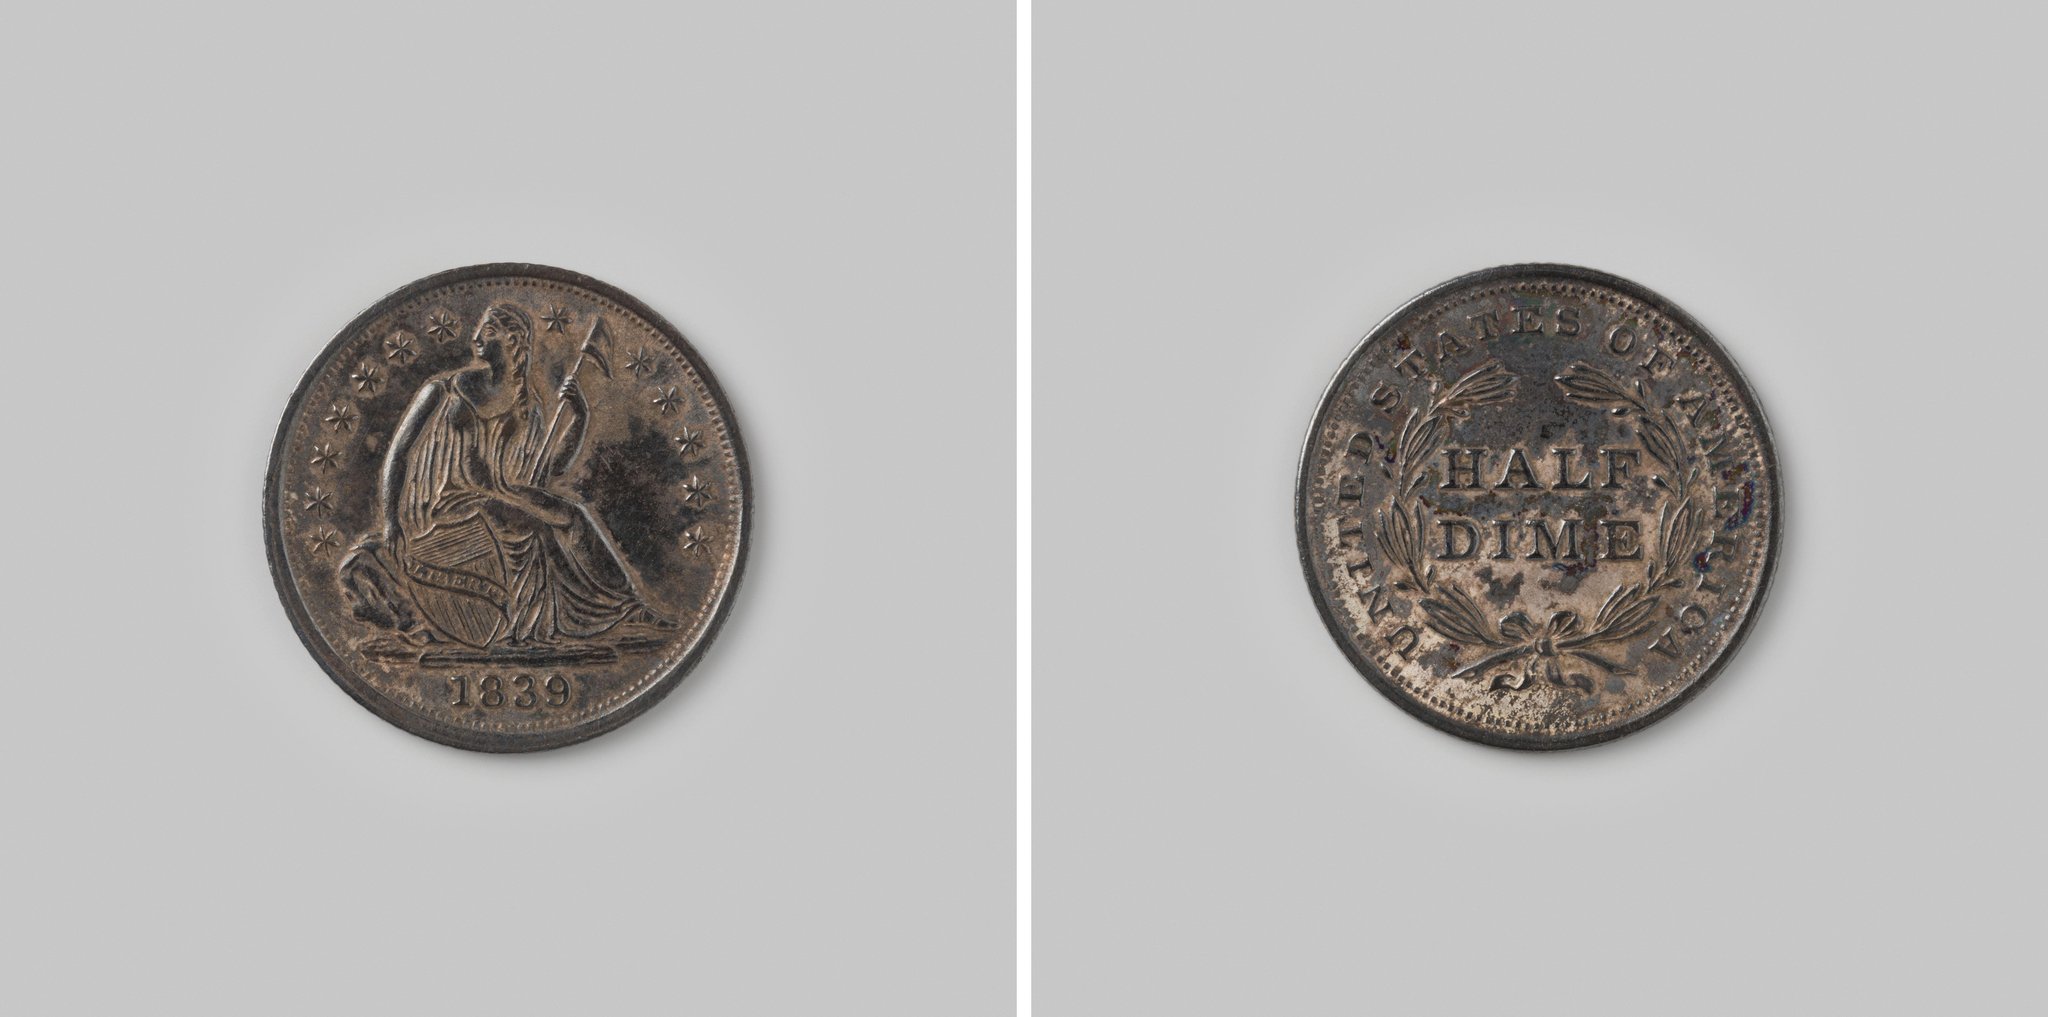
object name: coin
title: ½ dime of 5 cents uit de Verenigde Staten van Amerika, 1839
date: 1839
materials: silver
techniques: striking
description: Zilveren munt. Voorzijde: liberty seated, naar links omkijkend, met in de linkerhand speer met vaan en in rechterhand wapenschild. Daaromheen sterren. Onderaan jaartal. Keerzijde: tussen twee samengebonden takken in twee regels waarde-aanduiding: half dime. Kartelrand.